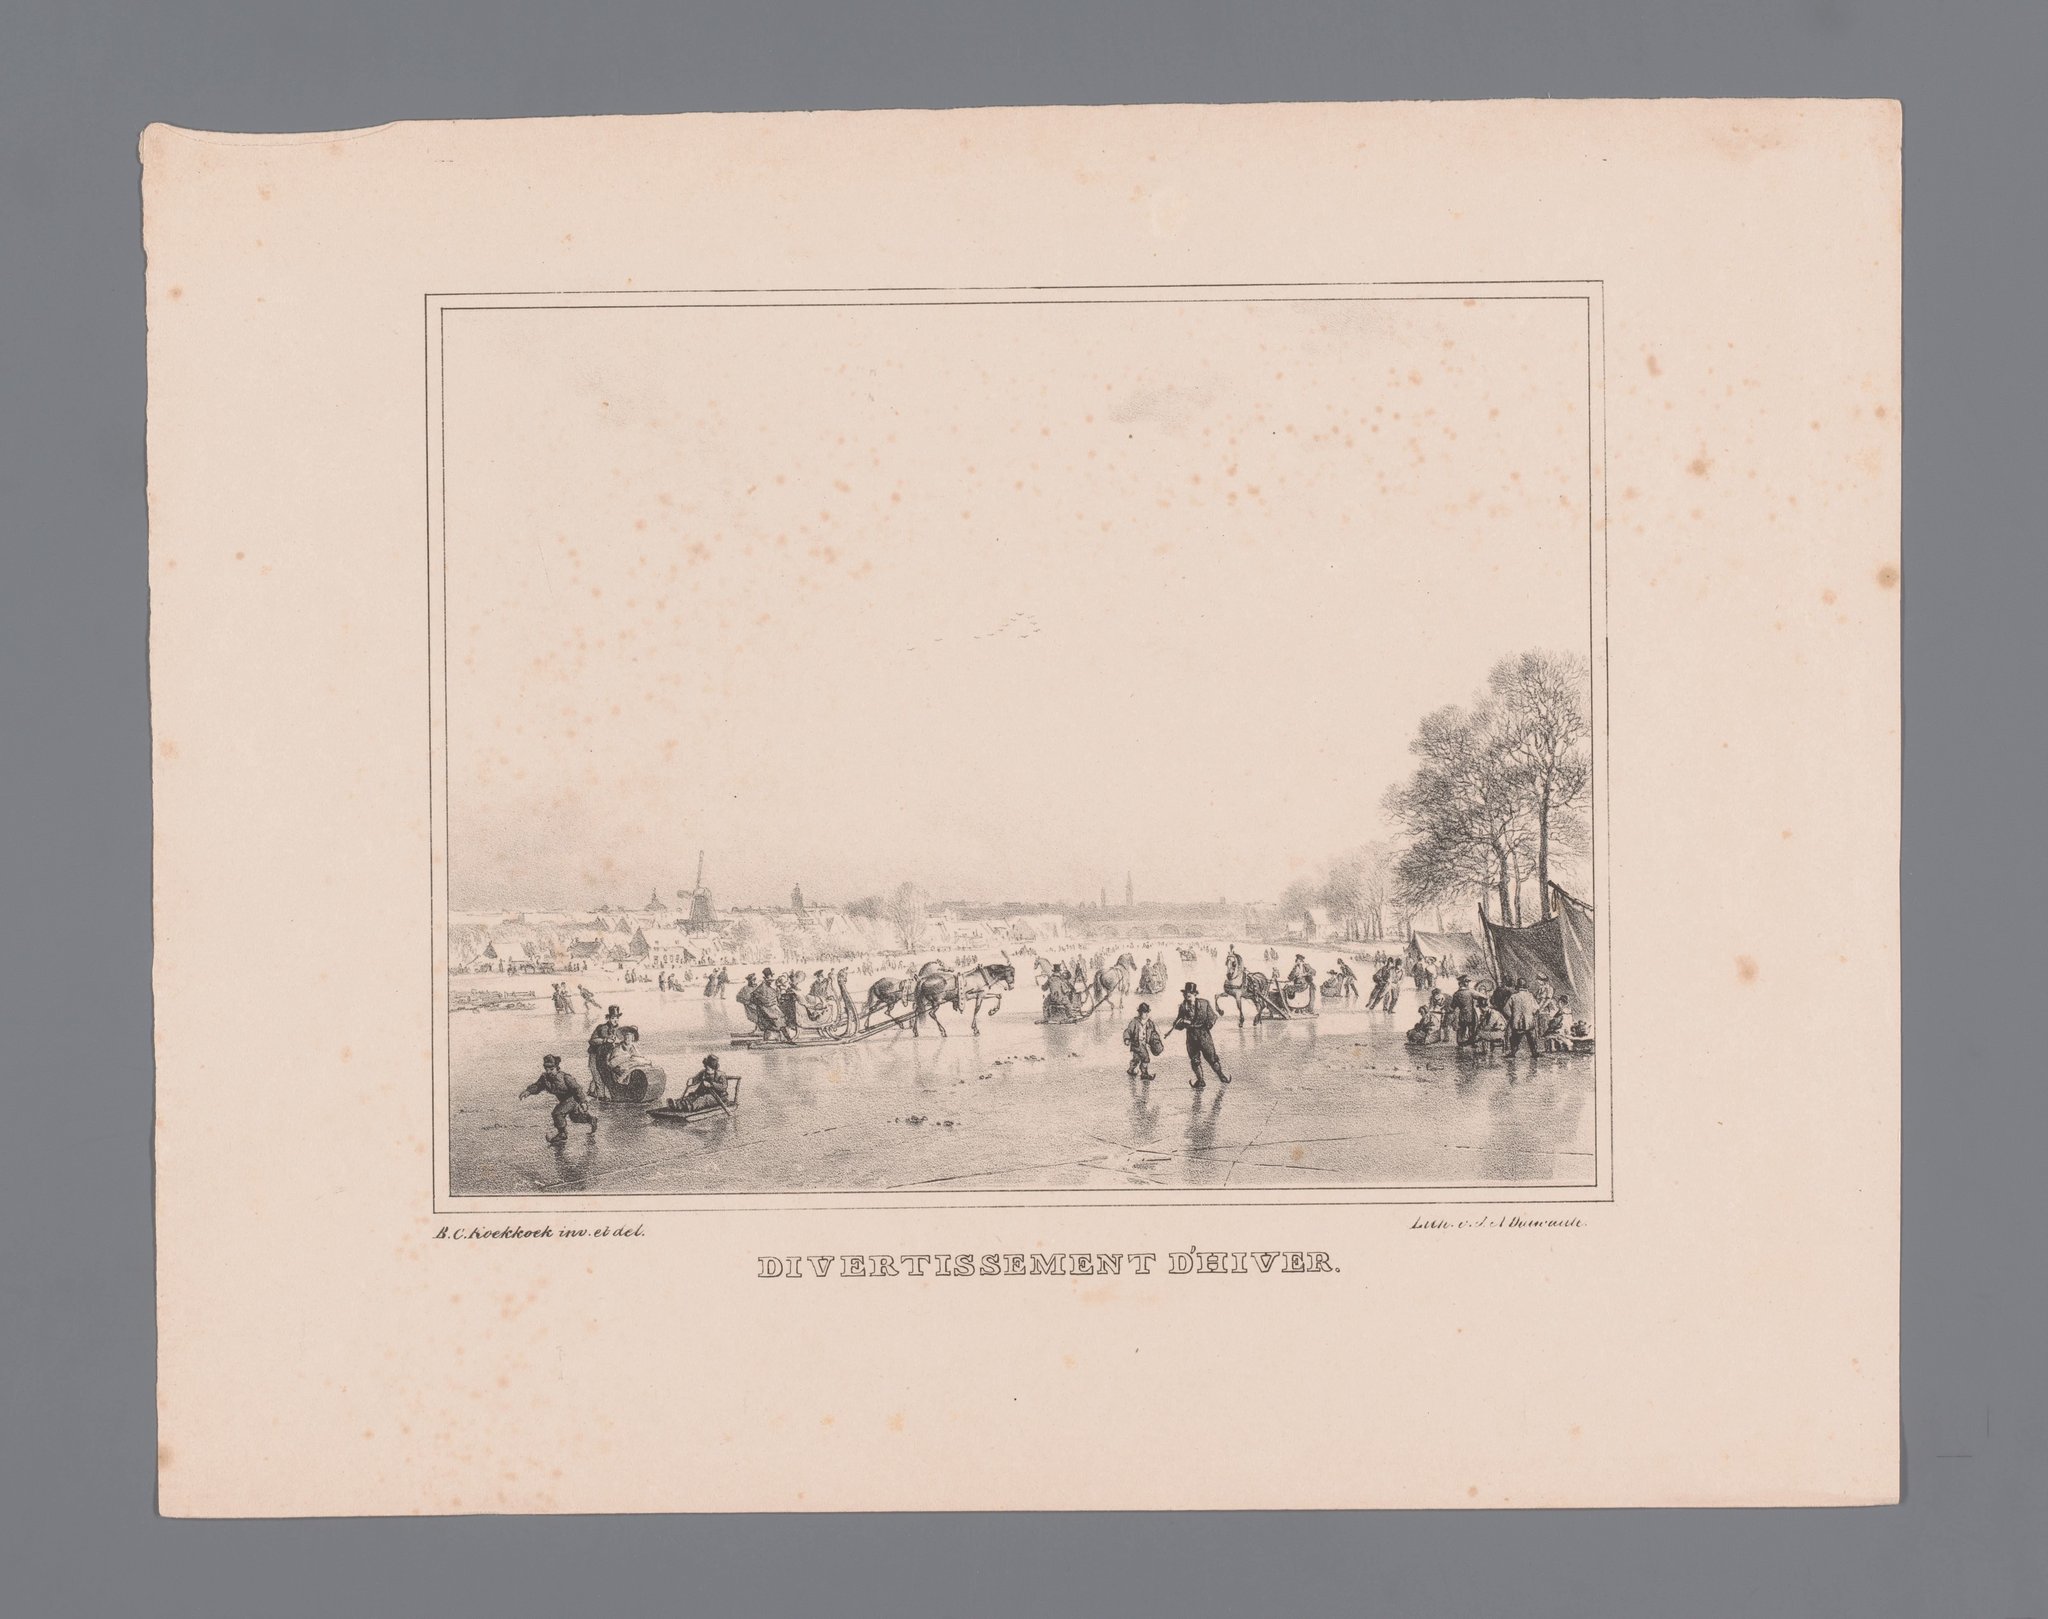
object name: print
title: Wintergezicht met figuren op het ijs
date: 1830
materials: paper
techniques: lithograph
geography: amsterdam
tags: winter landscape; landscape symbolizing winter (the four seasons of the year), skates (winter sports)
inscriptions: collector's mark: Lugt 2228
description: Links een dorp of stad. Op het ijs schaatsen, rijden en glijden figuren. Rechts koek en zopie kramen.